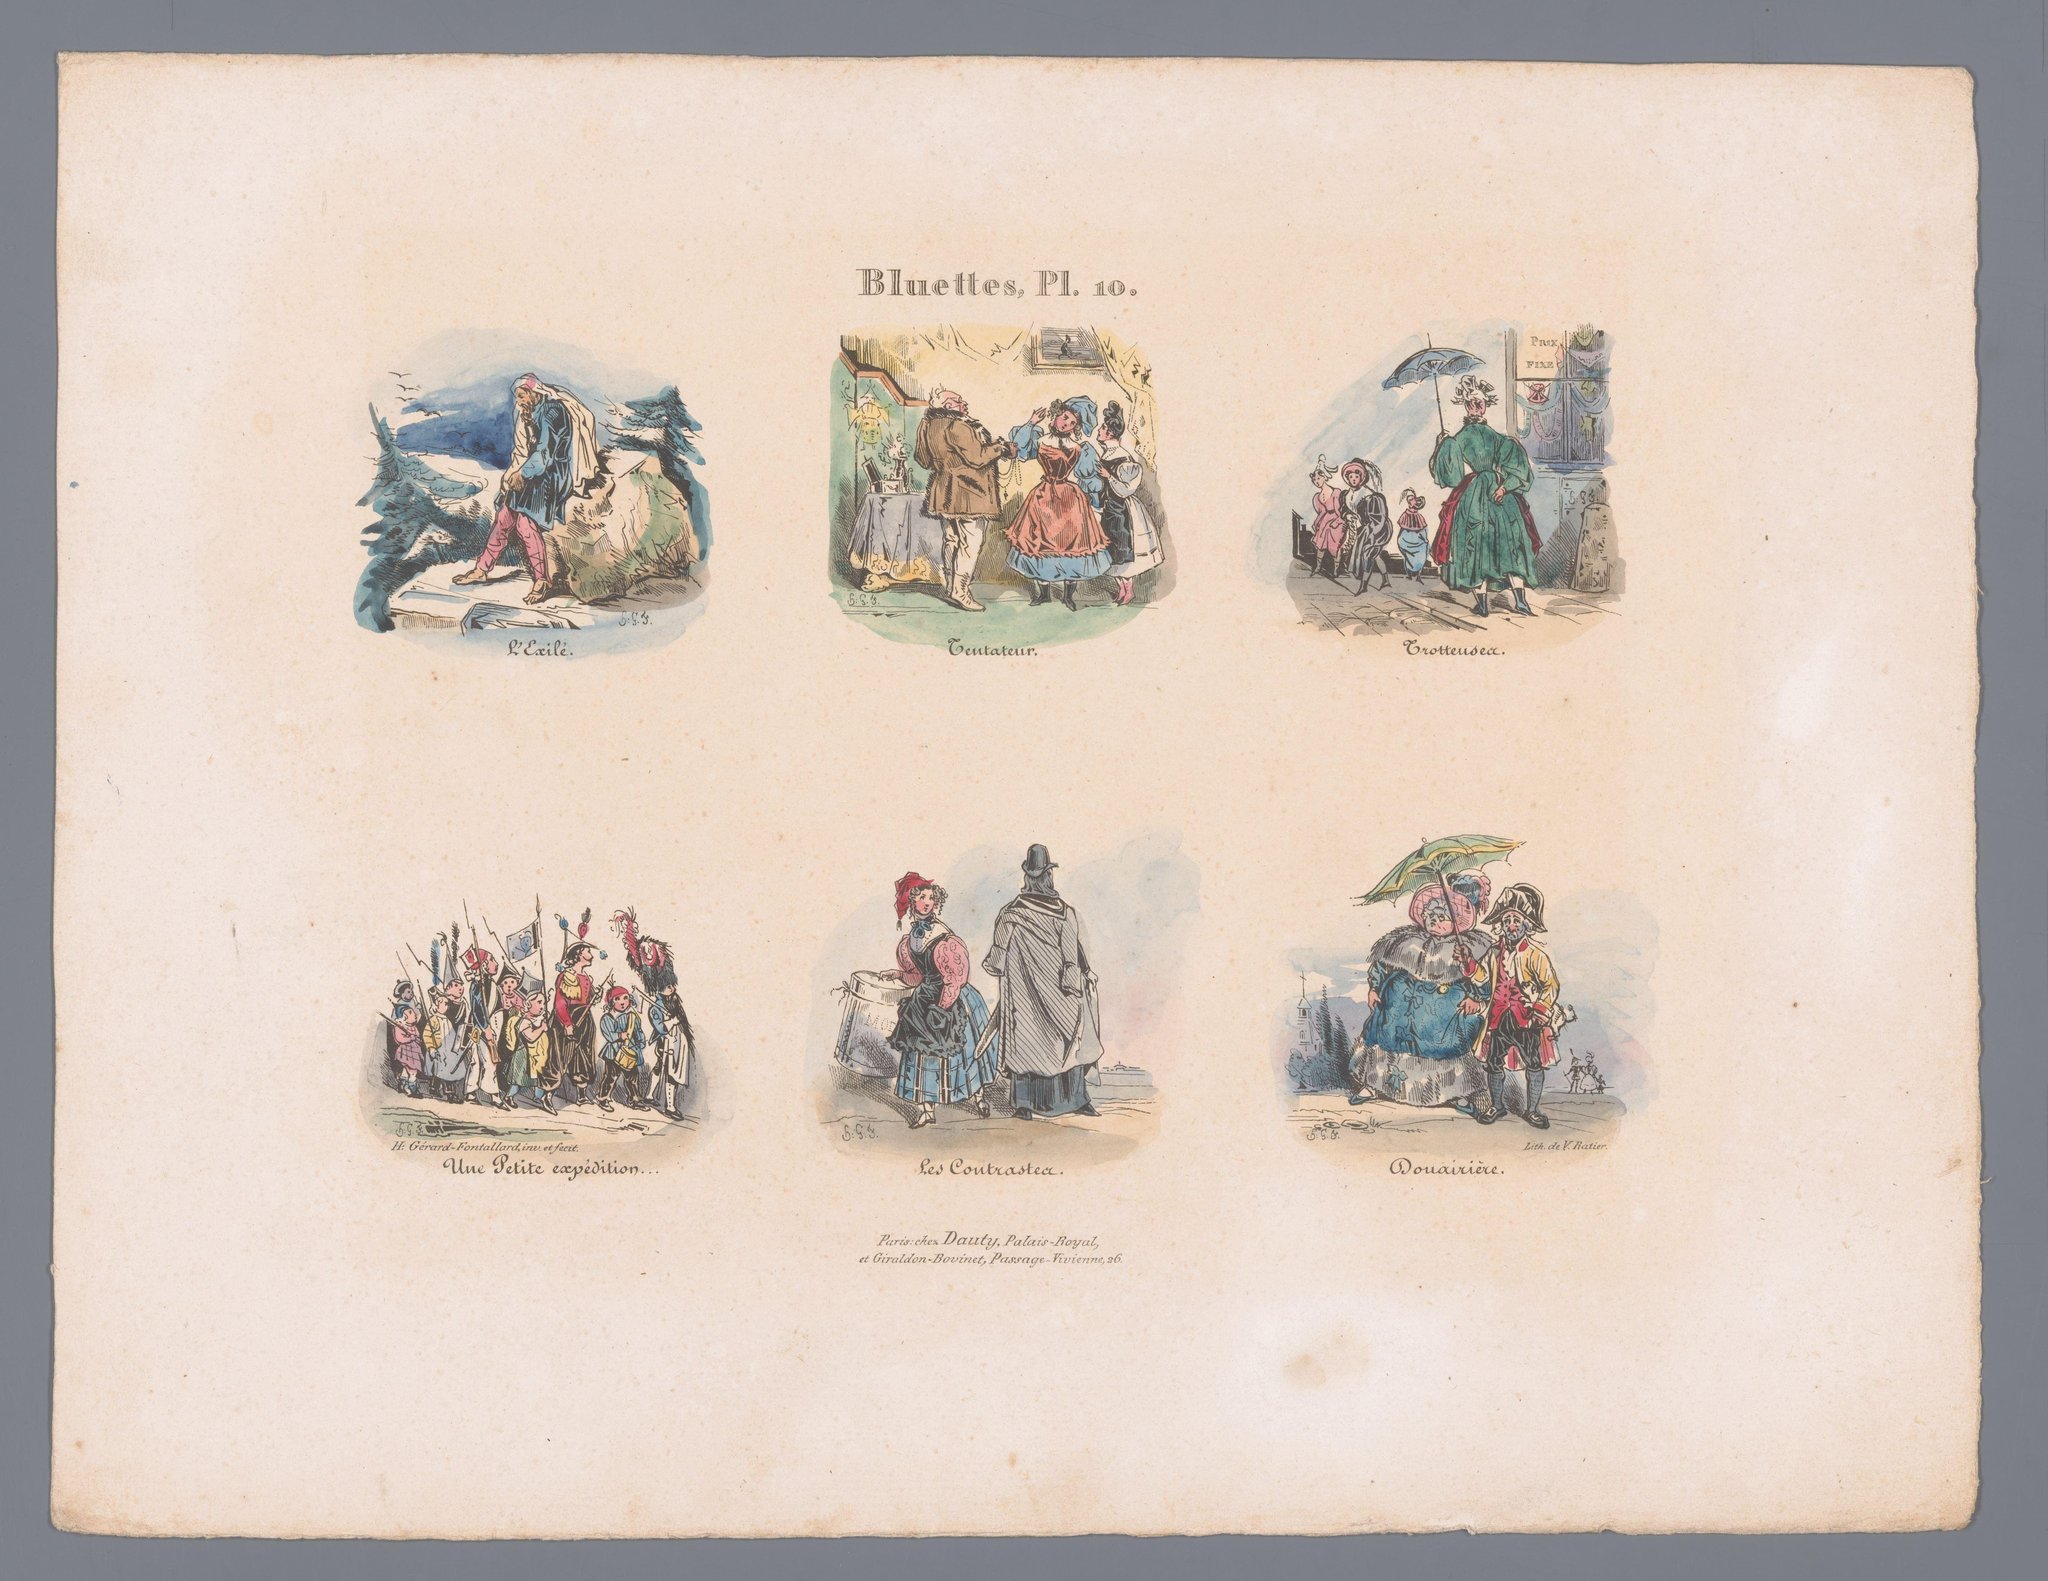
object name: print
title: Bluettes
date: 1829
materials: paper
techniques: hand coloring, lithograph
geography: paris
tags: various human types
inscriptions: collector's mark: Lugt 2228a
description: Prent maakt deel uit van een omslag met achttien prenten.